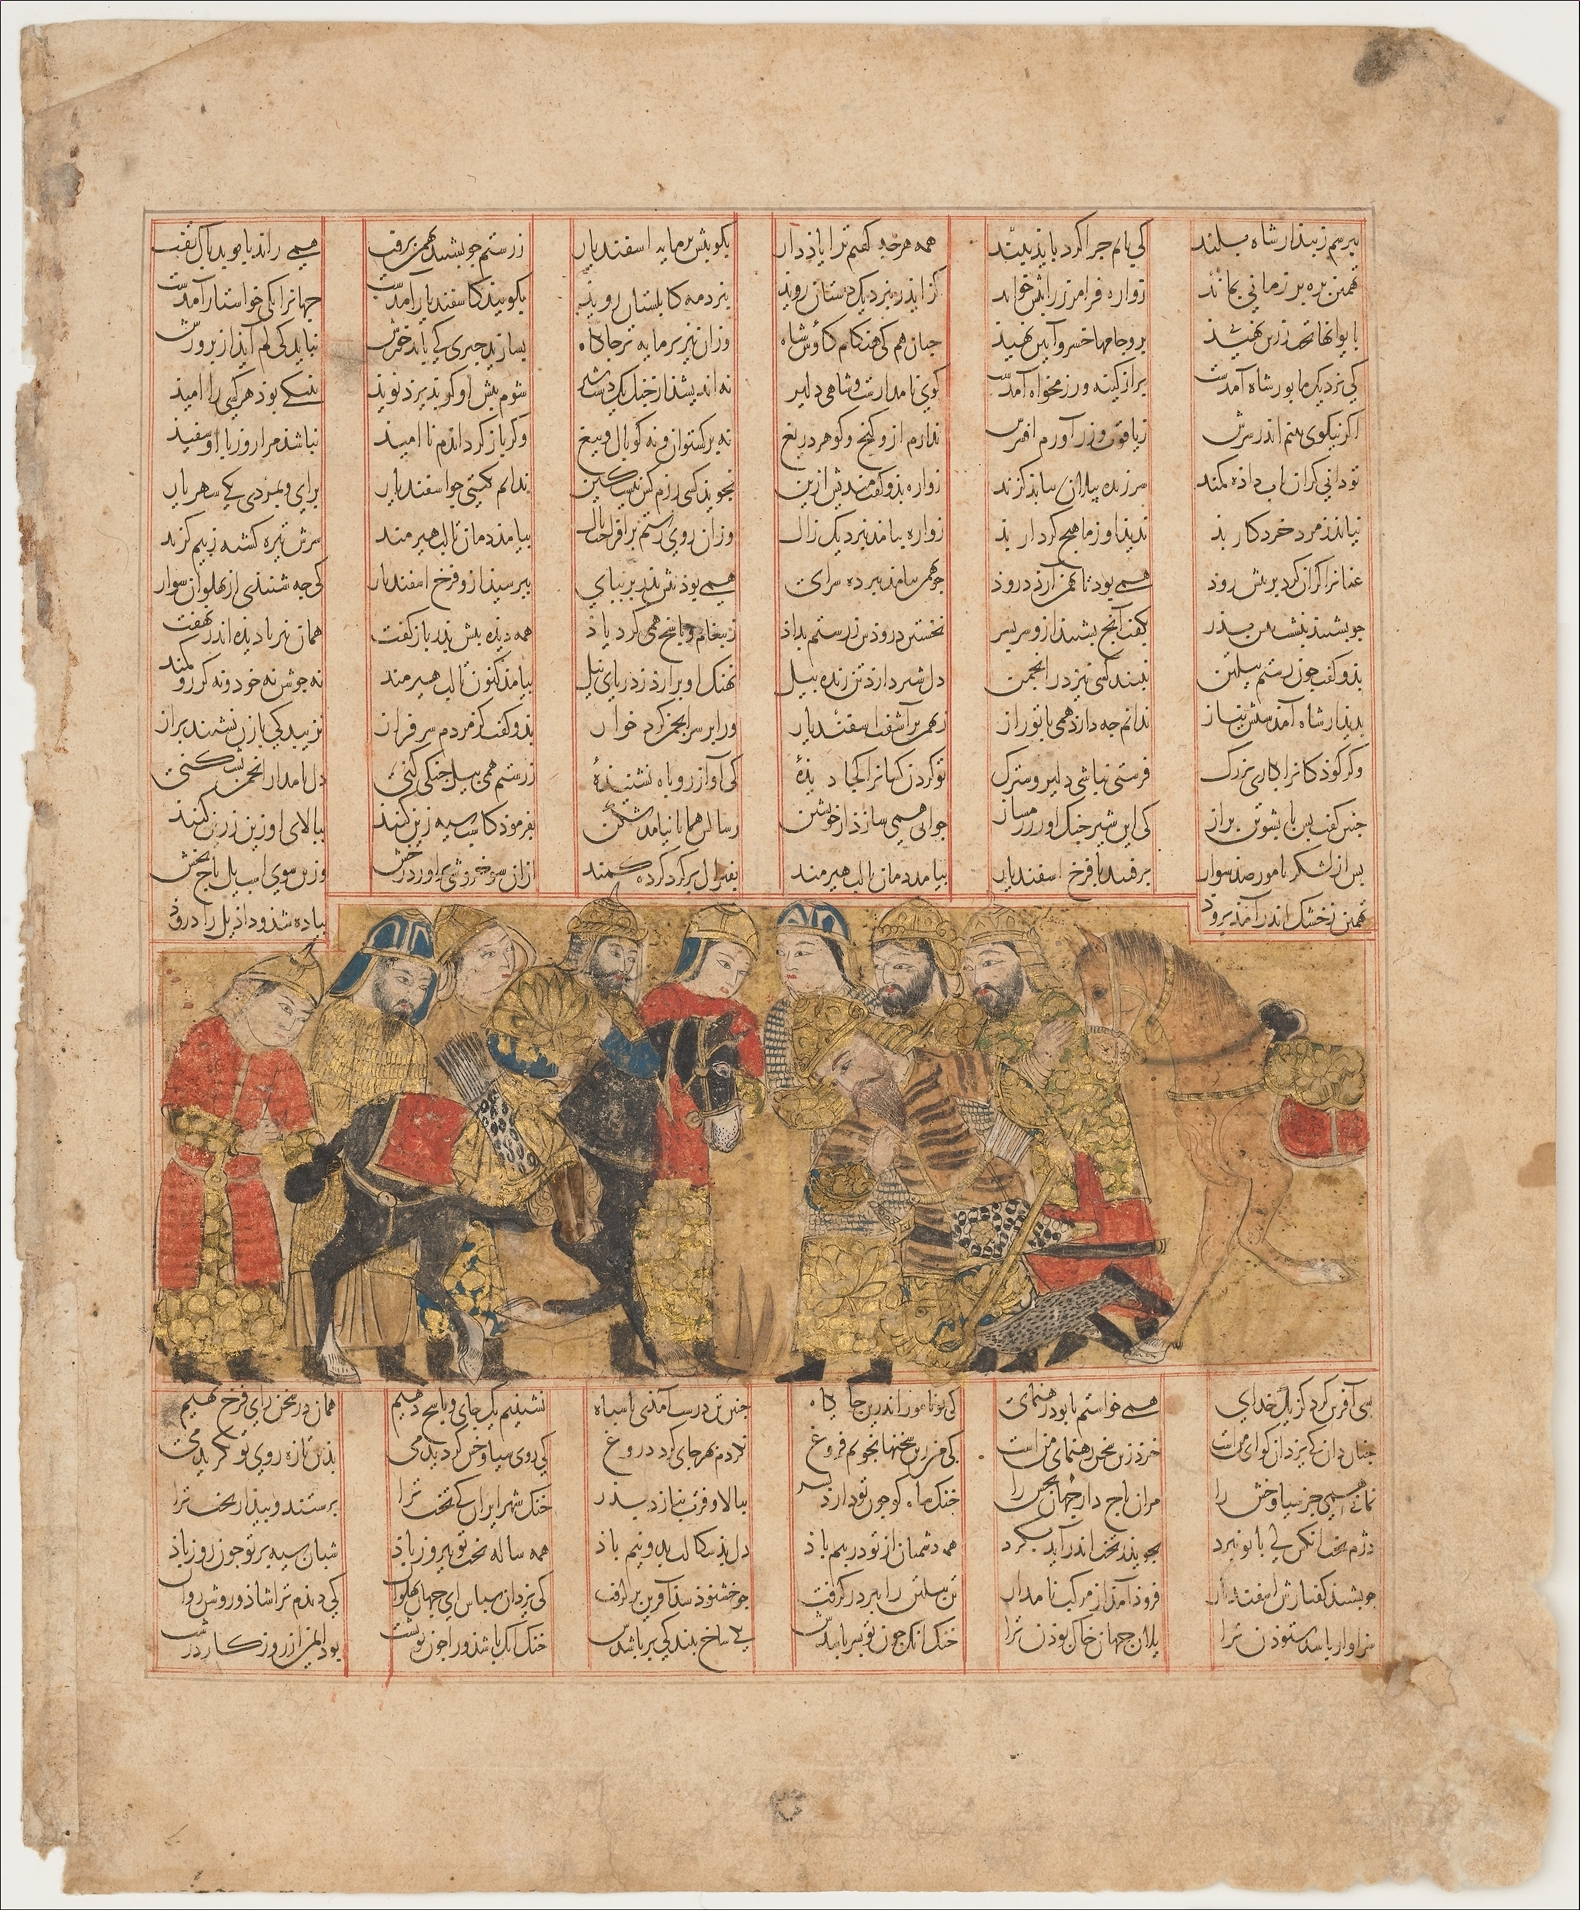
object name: folio from an illustrated manuscript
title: "Rustam Pleads for Tus Before Kai Khusrau," Folio from a Shahnama (Book of Kings)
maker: abu'l qasim firdausi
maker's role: author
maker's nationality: iranian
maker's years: 935-1020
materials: gold, ink, paper, watercolor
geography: iran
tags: poetry,men,horses